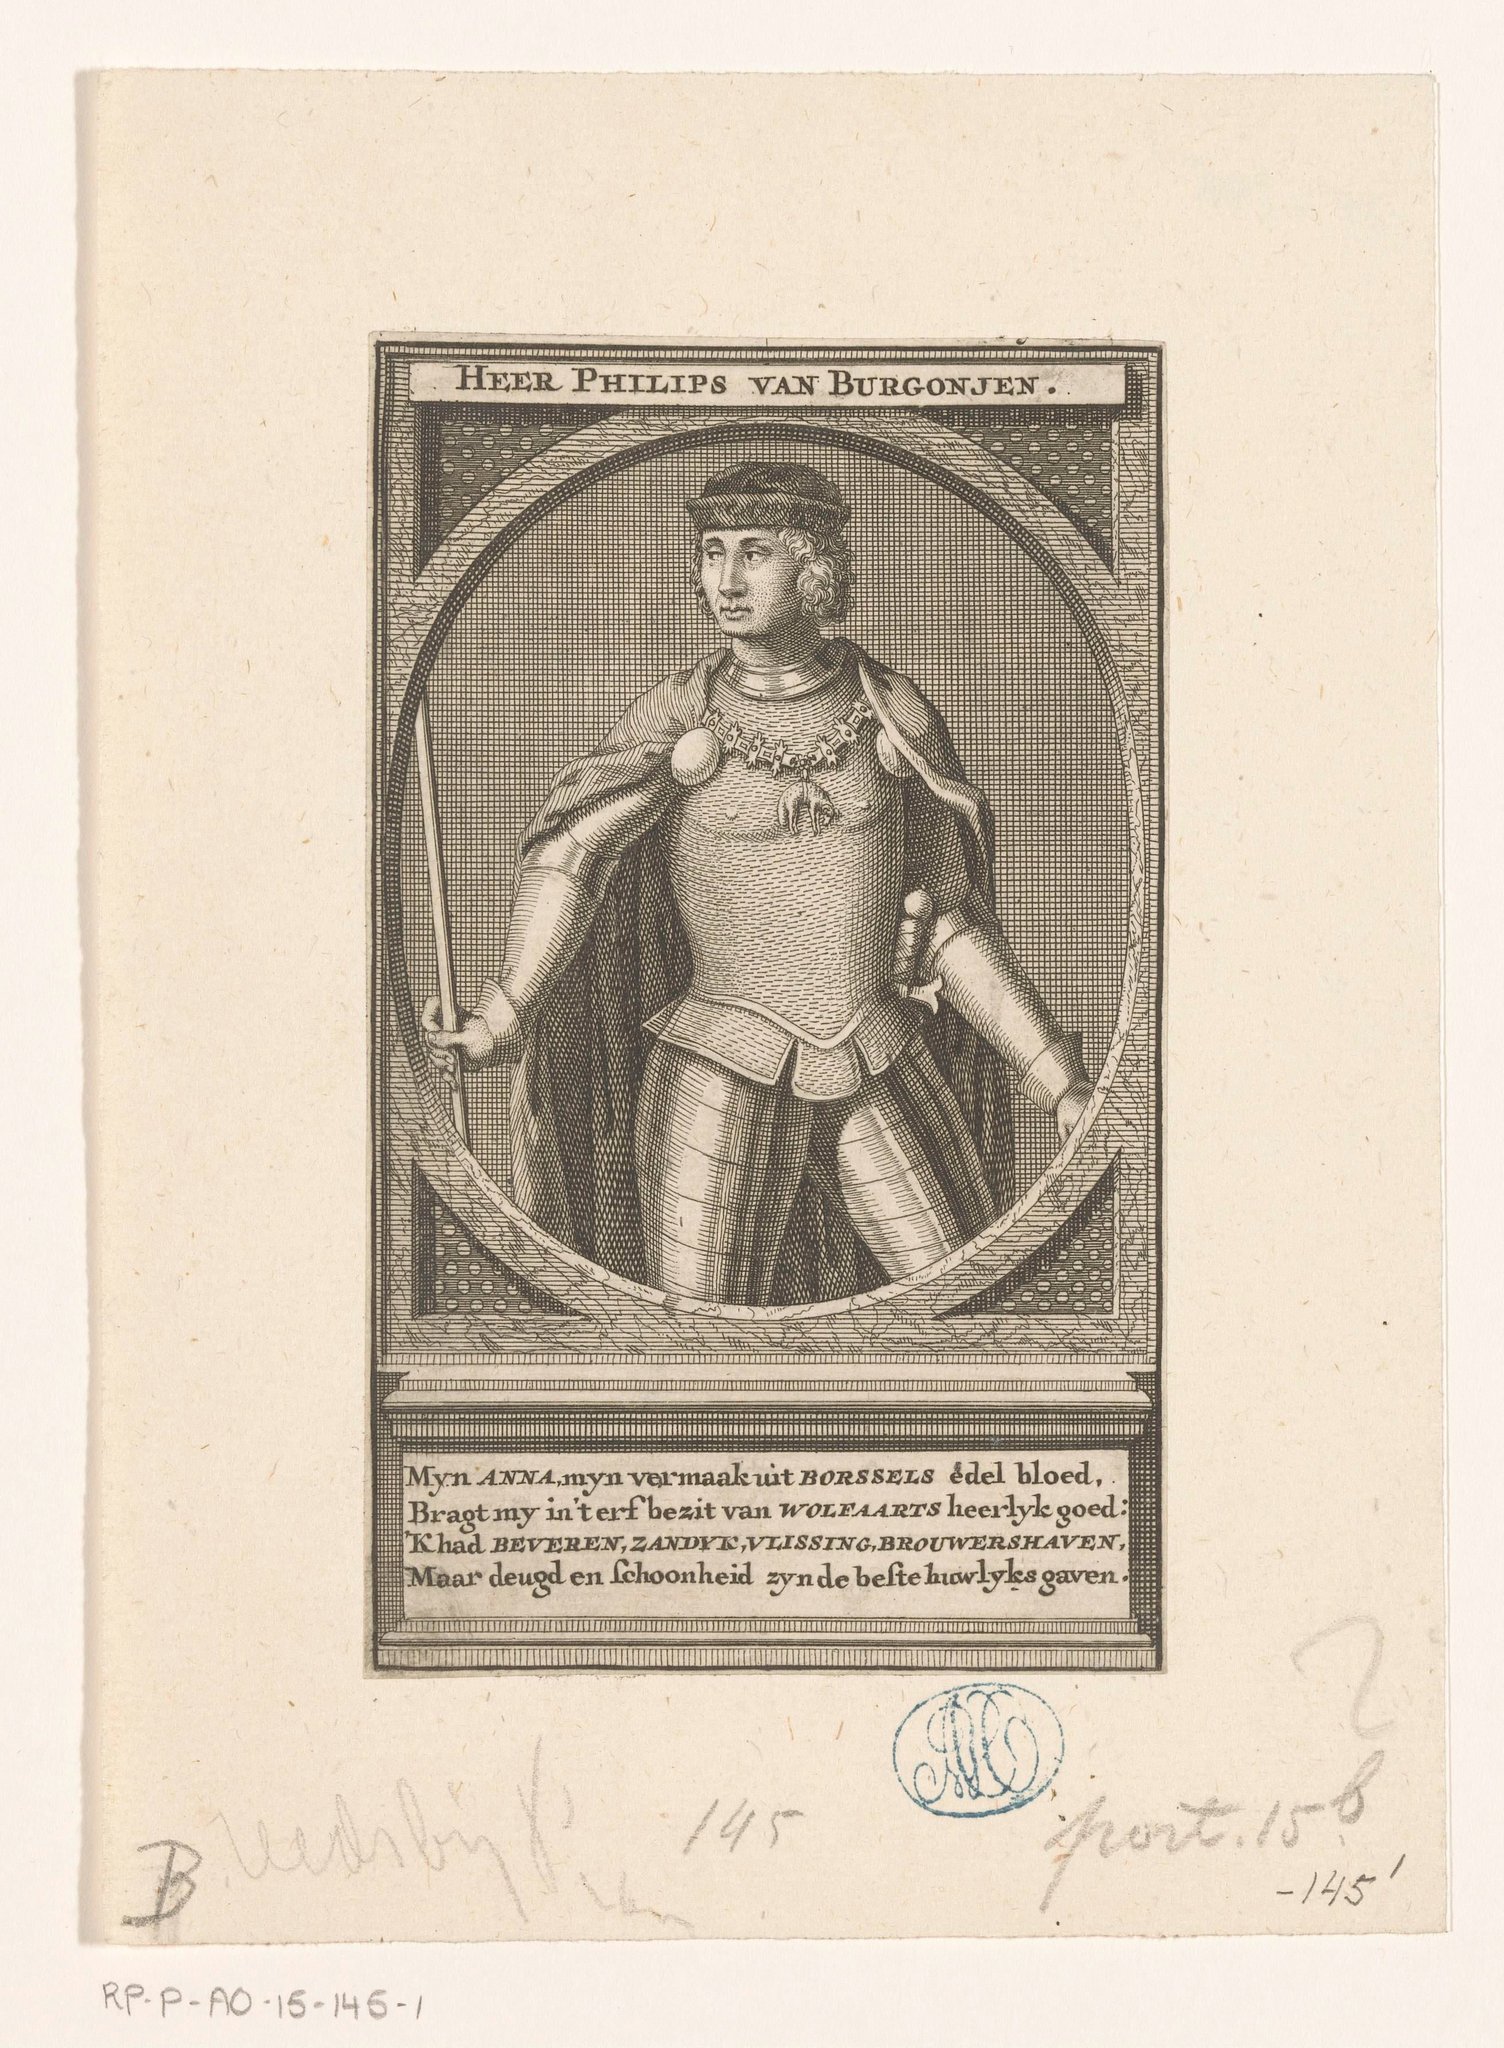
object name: print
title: Heer Philips van Burgonjen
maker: Anonymous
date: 1715-1755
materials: paper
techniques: engraving, etching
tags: historical persons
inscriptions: collector's mark: Lugt 195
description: Prent ook gebruikt in: Gargon, Mattheus. Walchersche arkadia, waar in op een zoetvoerigen trant (…). 2 delen. Leiden: Samuel Luchtmans, 1715-1717, dl. 1 (1715), p. 108. En in: Gargon, Mattheus. Walchersche arkadia, waar in op een zoetvoerigen trant (…). 2 delen. Leiden: Samuel Luchtmans en Zoon, 1746, dl. 1, p. 108. En in: Gargon, Mattheus. Walchersche arkadia, waar in op een zoetvoerigen trant (…). 2 delen. Middelburg: M.H. en A.L. Callenfels, S. Mandelgreen, P. Gillissen en L. Taillefert, 1755, dl. 1, p. 108.